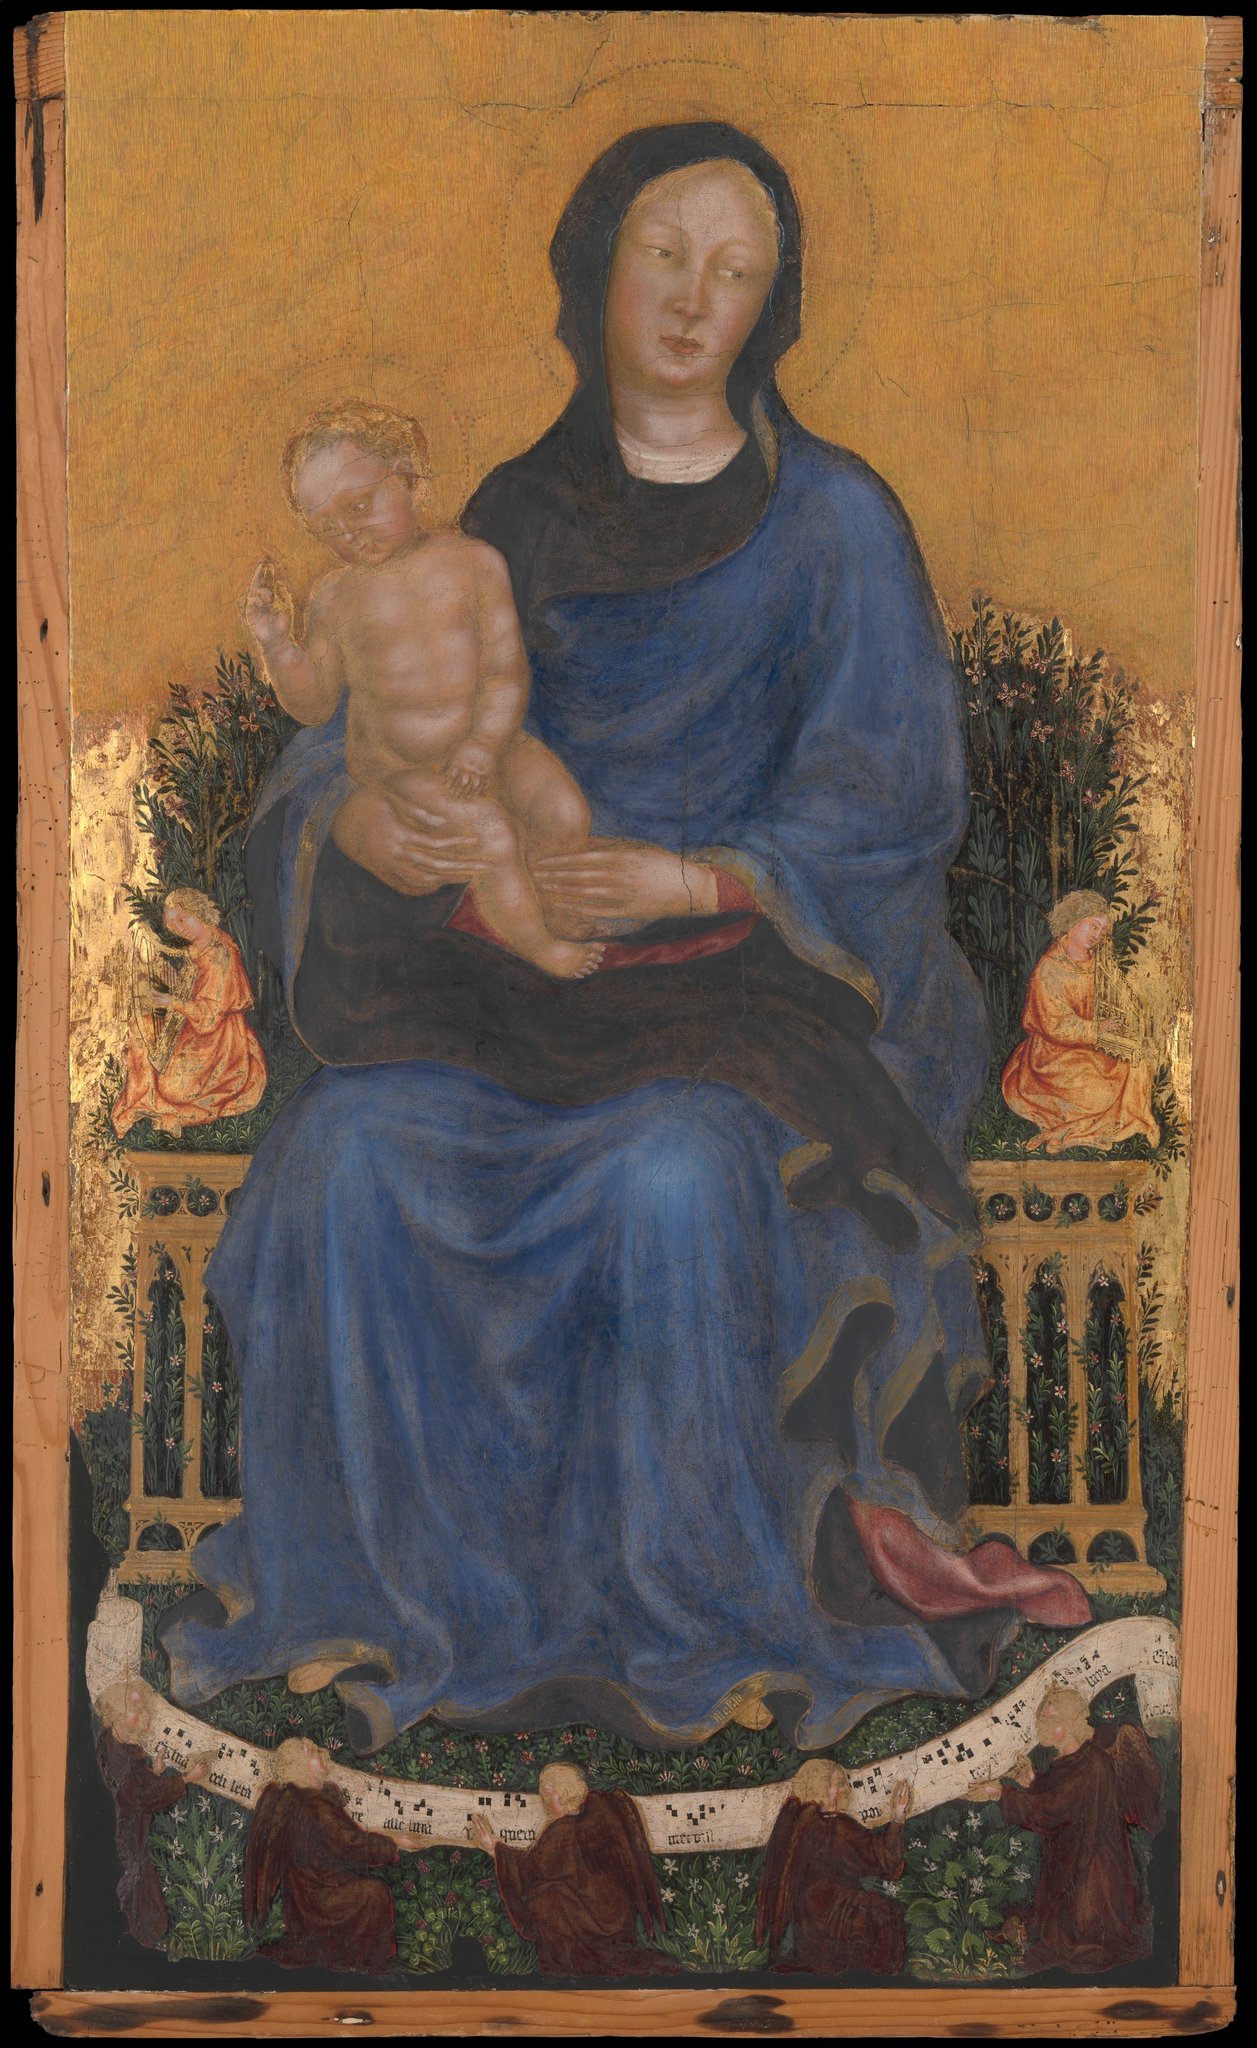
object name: painting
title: Madonna and Child with Angels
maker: gentile da fabriano (gentile di niccolò di giovanni di massio)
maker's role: artist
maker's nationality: italian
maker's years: 1408-1427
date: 1408-1427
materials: gold leaf, paint, wood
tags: angels,madonna and child